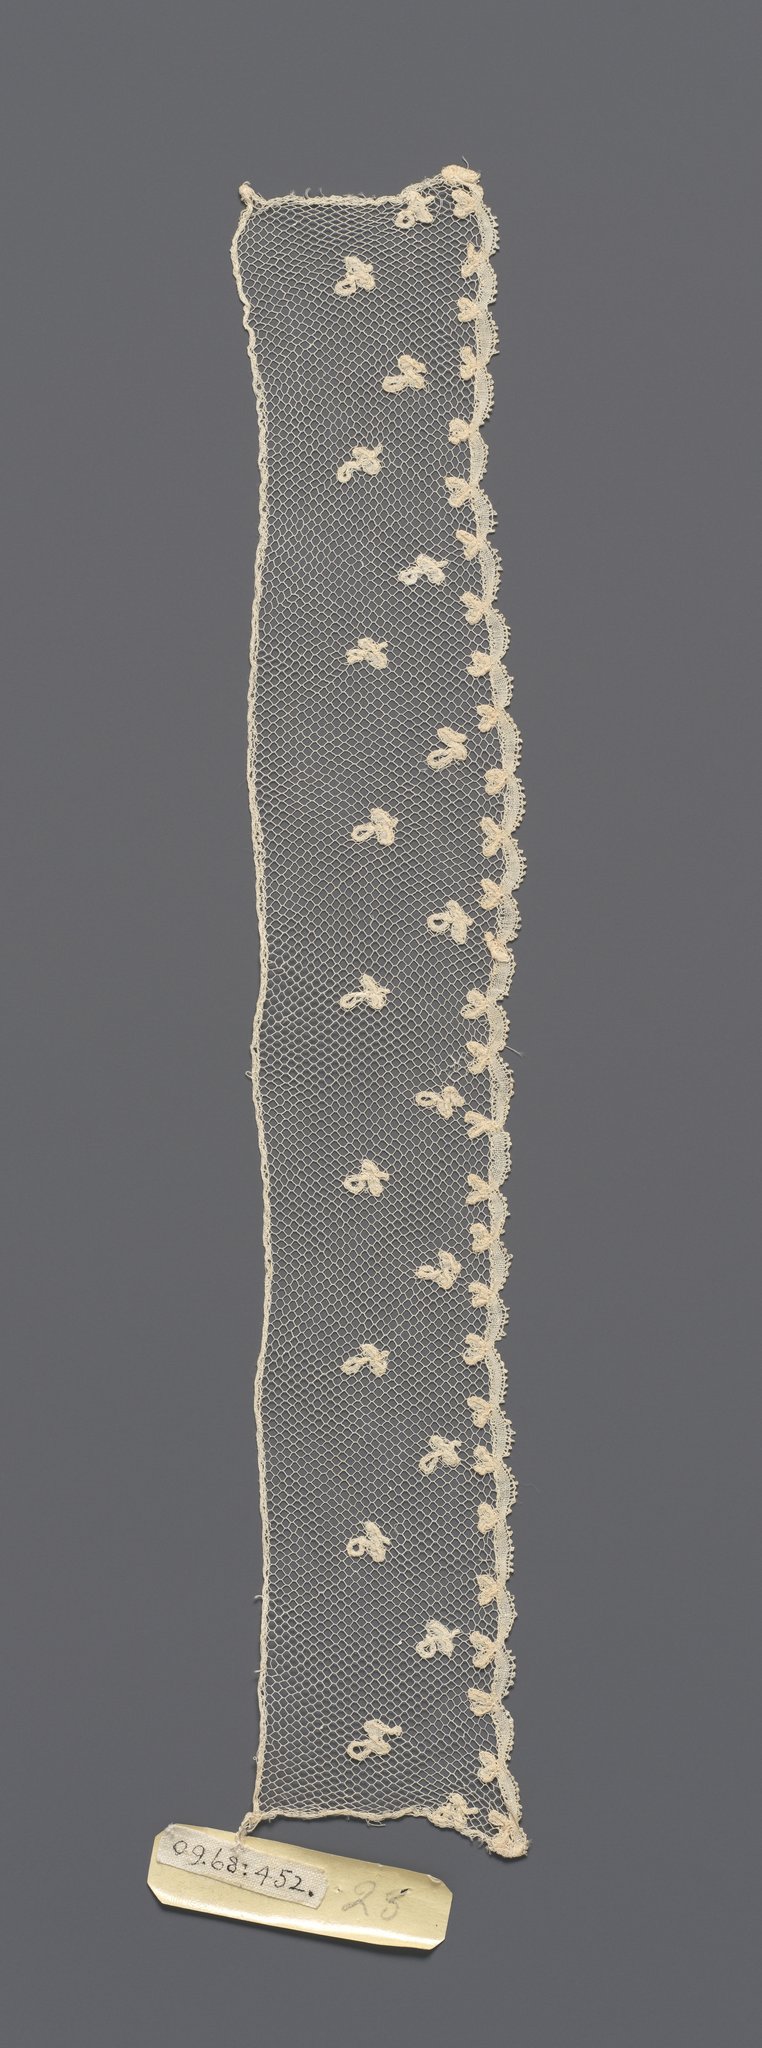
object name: fragment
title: Fragment of lace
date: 1801-1900